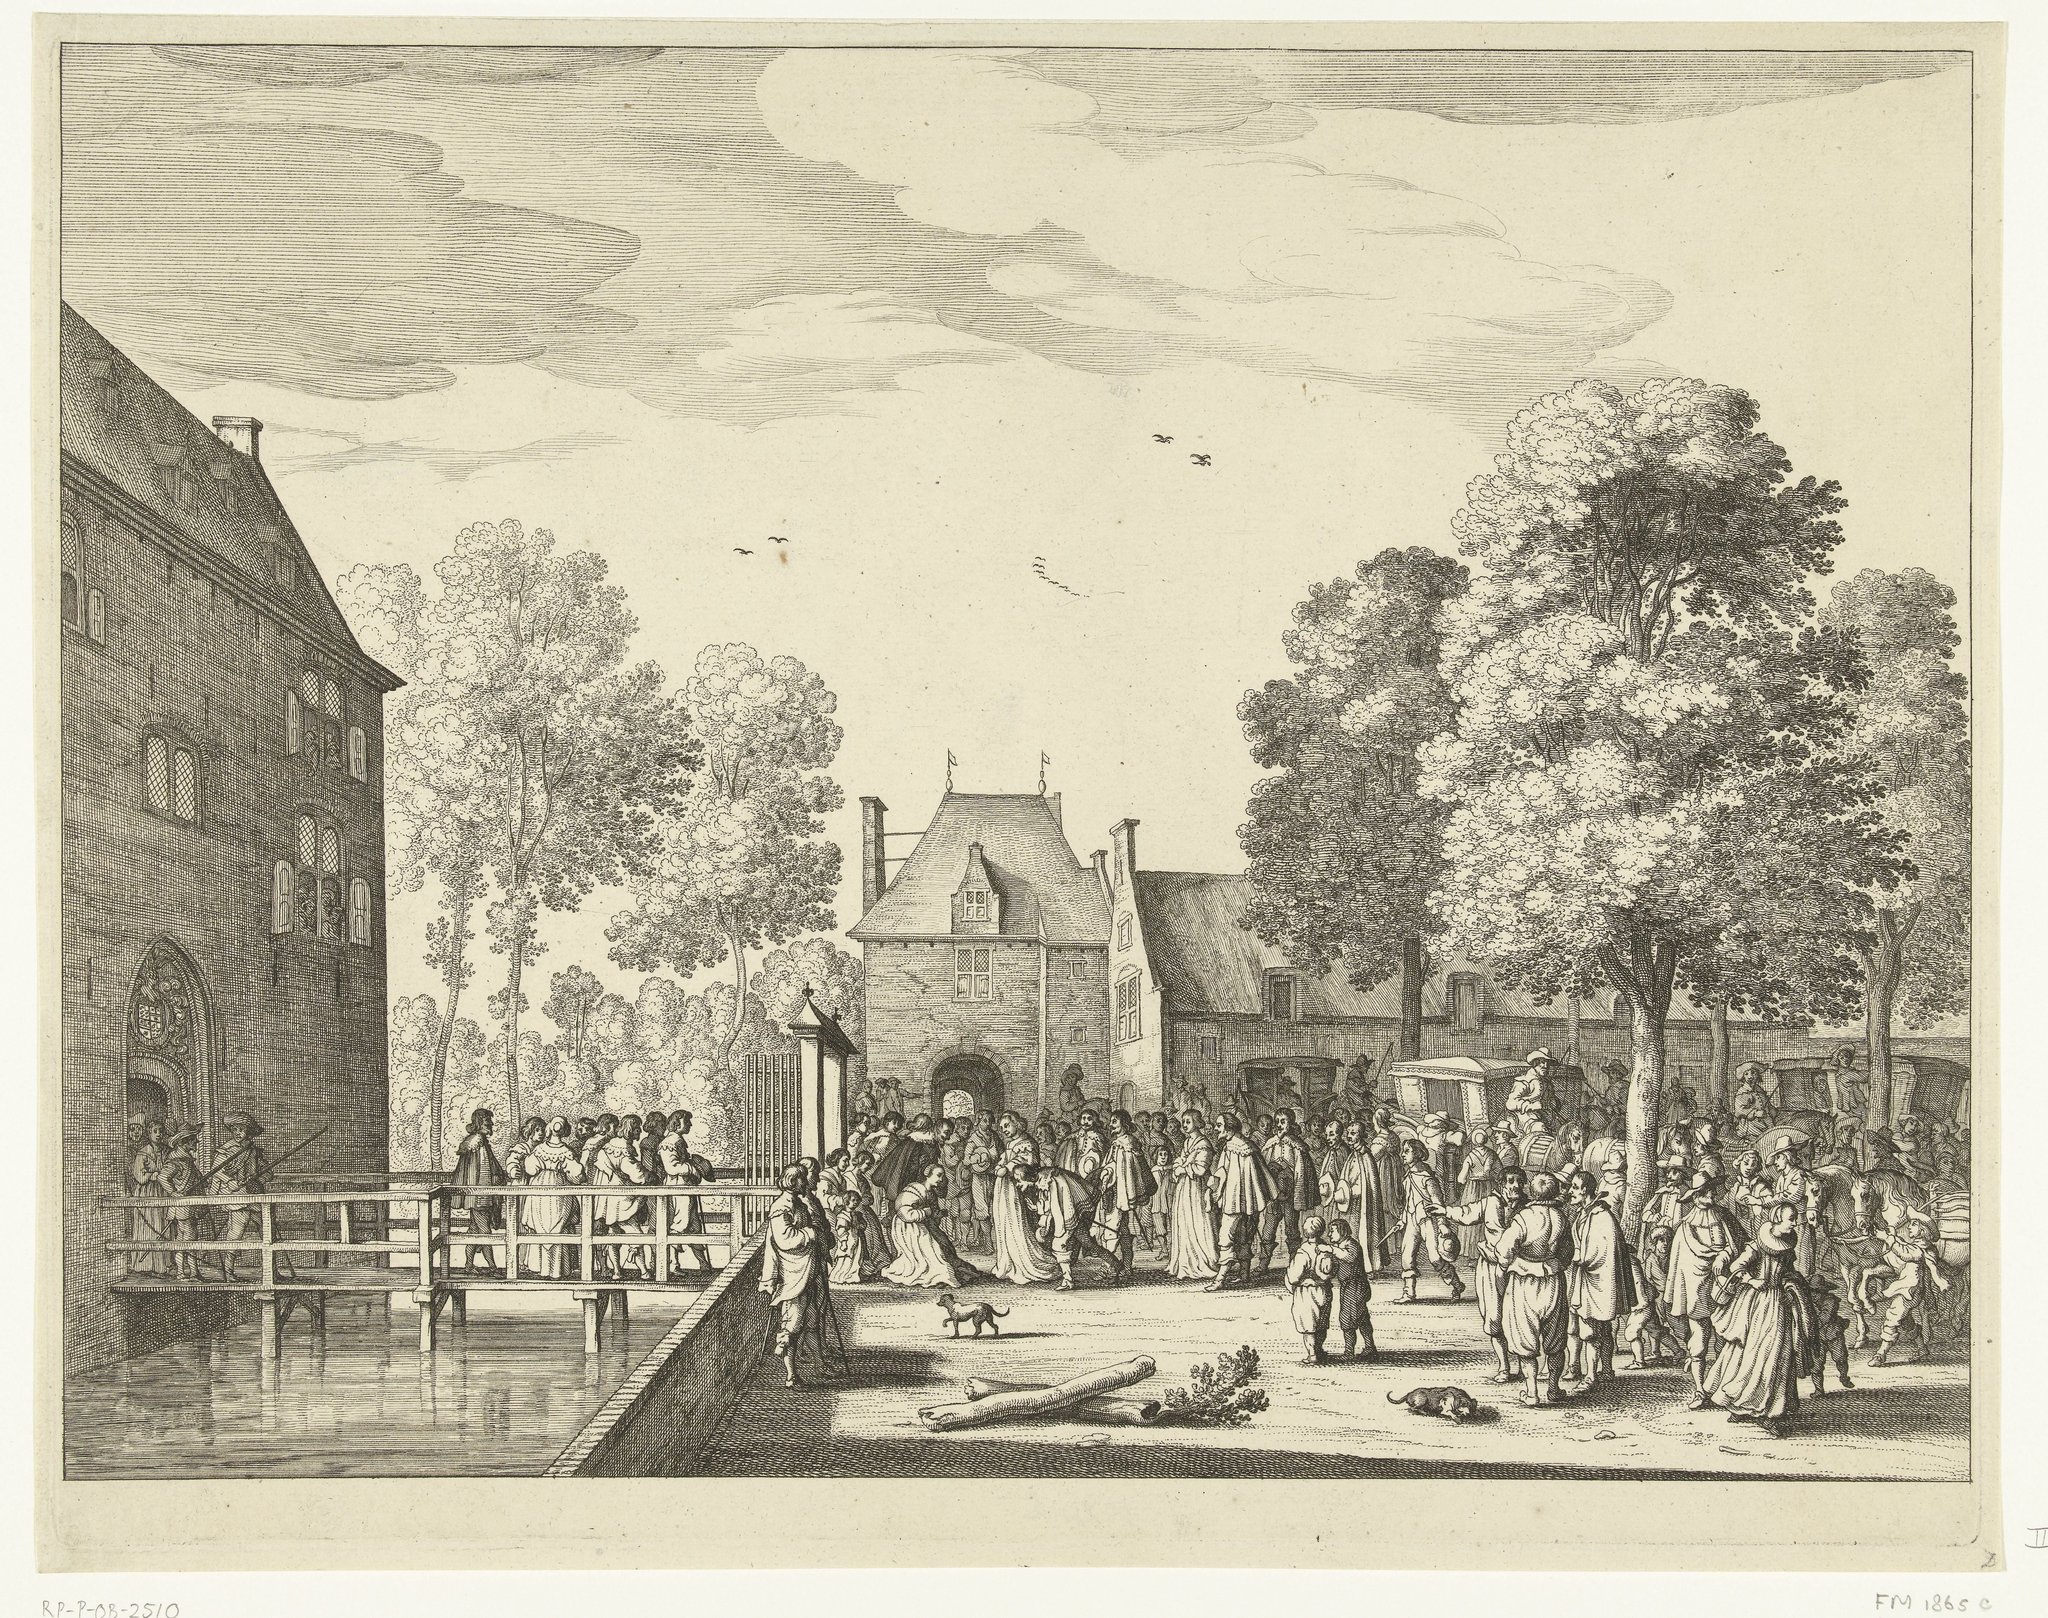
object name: print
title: Bezoek van koningin Henrietta Maria aan Adriaen Pauw op het Slot te Heemstede, 1642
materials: paper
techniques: etching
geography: northern netherlands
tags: henriëtta maria van frankrijk (koningin van engeland, schotland en ierland), william ii (prince of orange), amsterdam, the hague, politician, adriaen pauw (1585-1653), castle, visiting; receiving guests; elegant company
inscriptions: collector's mark: Lugt 2228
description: Tweede staat vóór het onderschrift, met de lucht. Een gesigneerde tekening door Jan Martszen de Jonge in spiegelbeeld in particuliere verzameling te Den Haag (in 1977) is mogelijk de ontwerptekening voor deze prent.